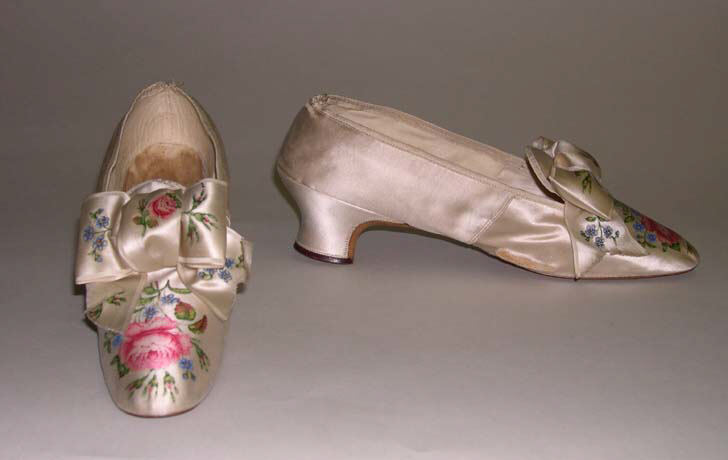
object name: accessory set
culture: british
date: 1870-1879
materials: silk